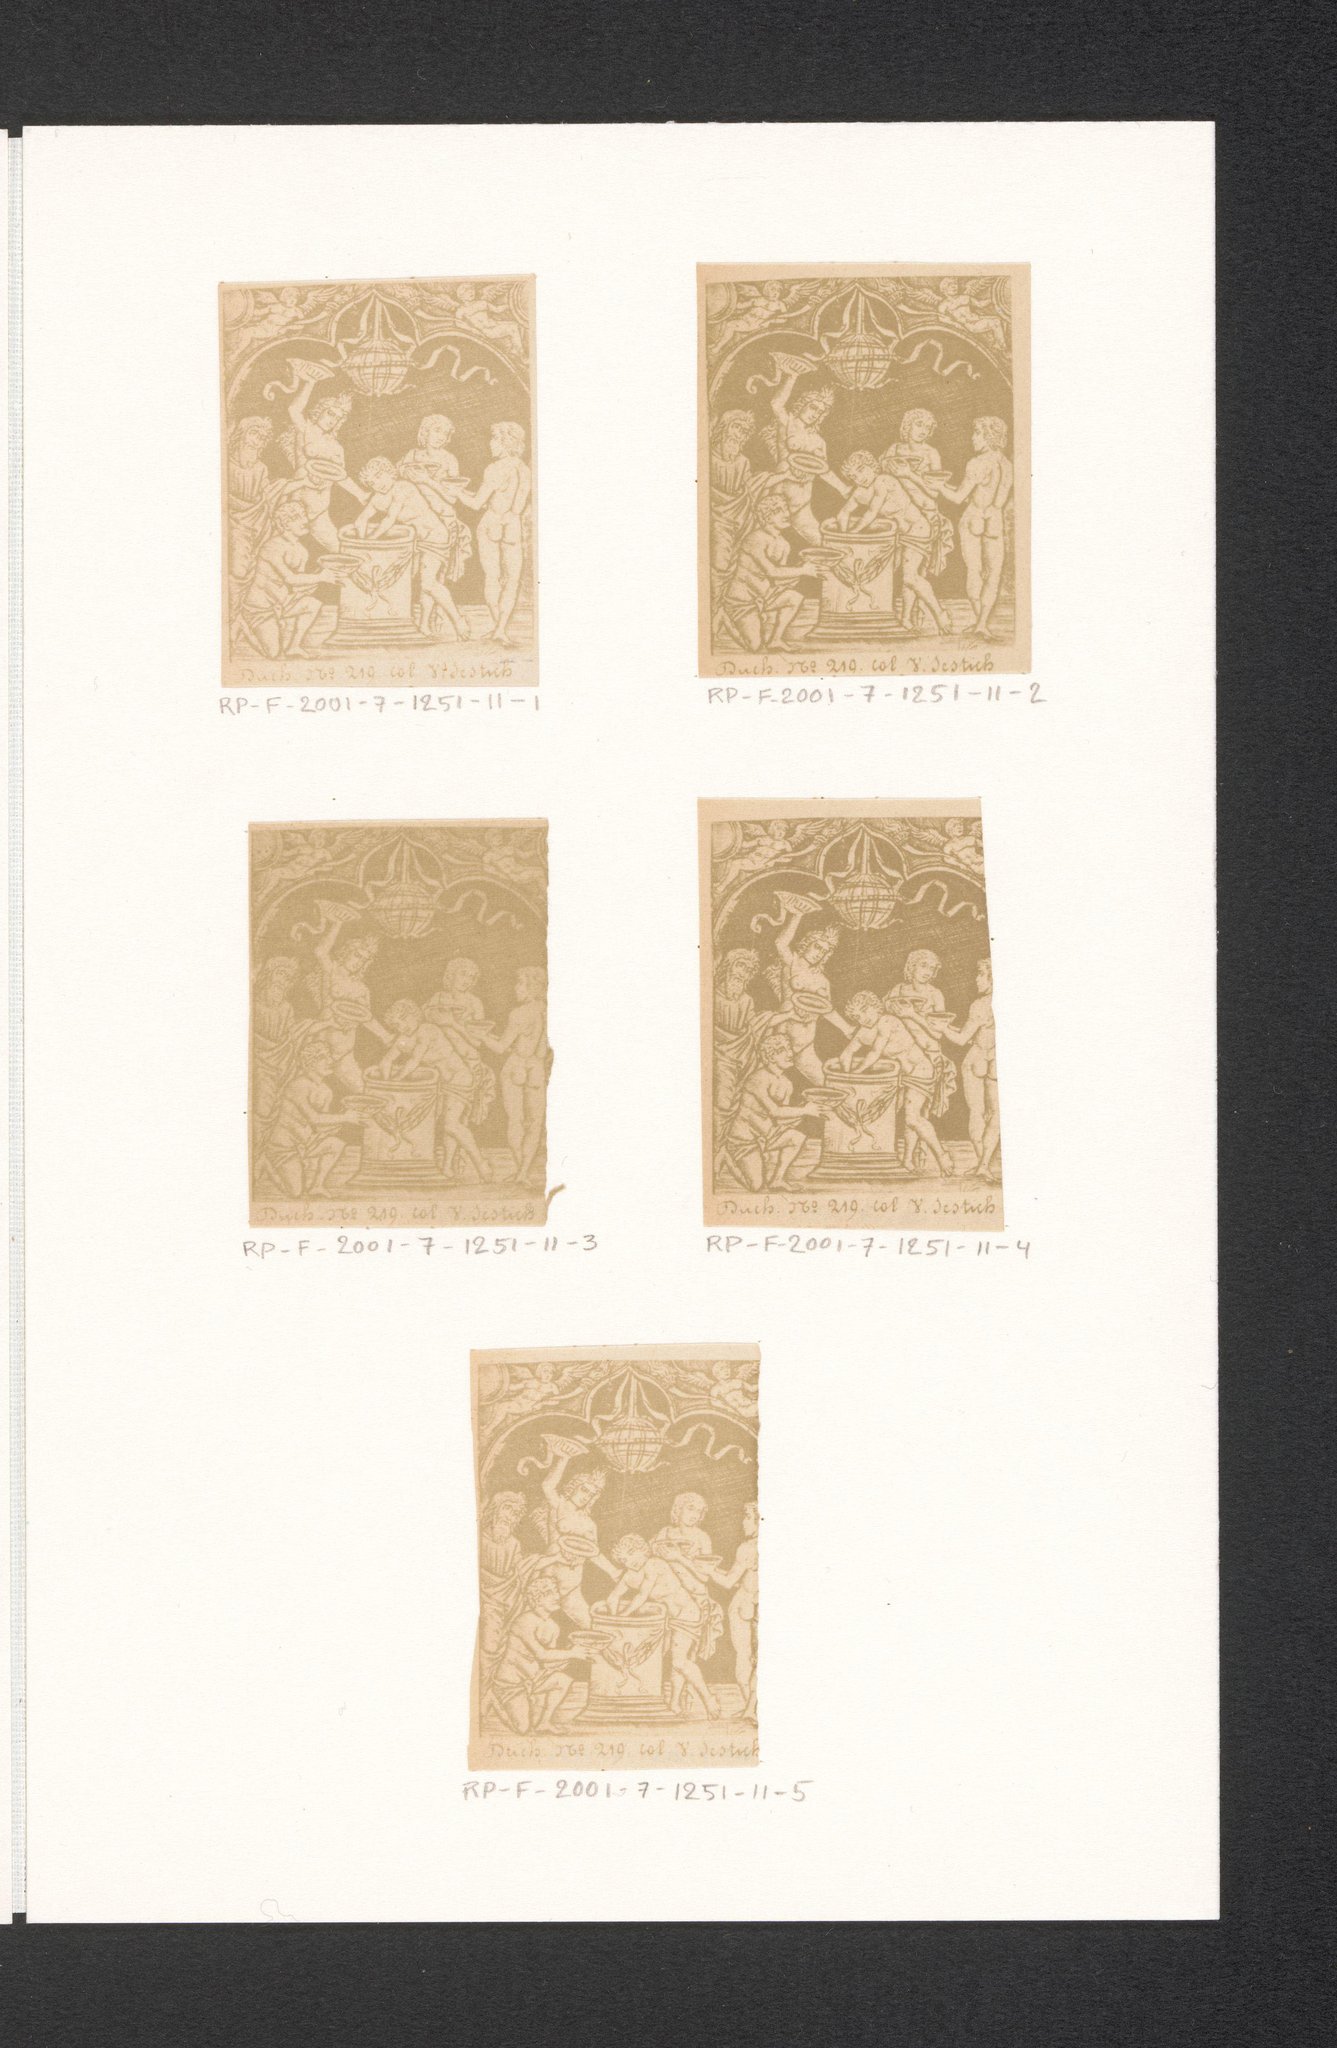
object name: page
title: Fotoreproductie van een prent van een bacchanaal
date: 1852-1857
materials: photographic support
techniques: salted paper print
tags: bacchanal: bacchus with his wine-flushed train (thiasos)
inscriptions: inscription: ‘Duch. No 21[9]. col V. Sestich’